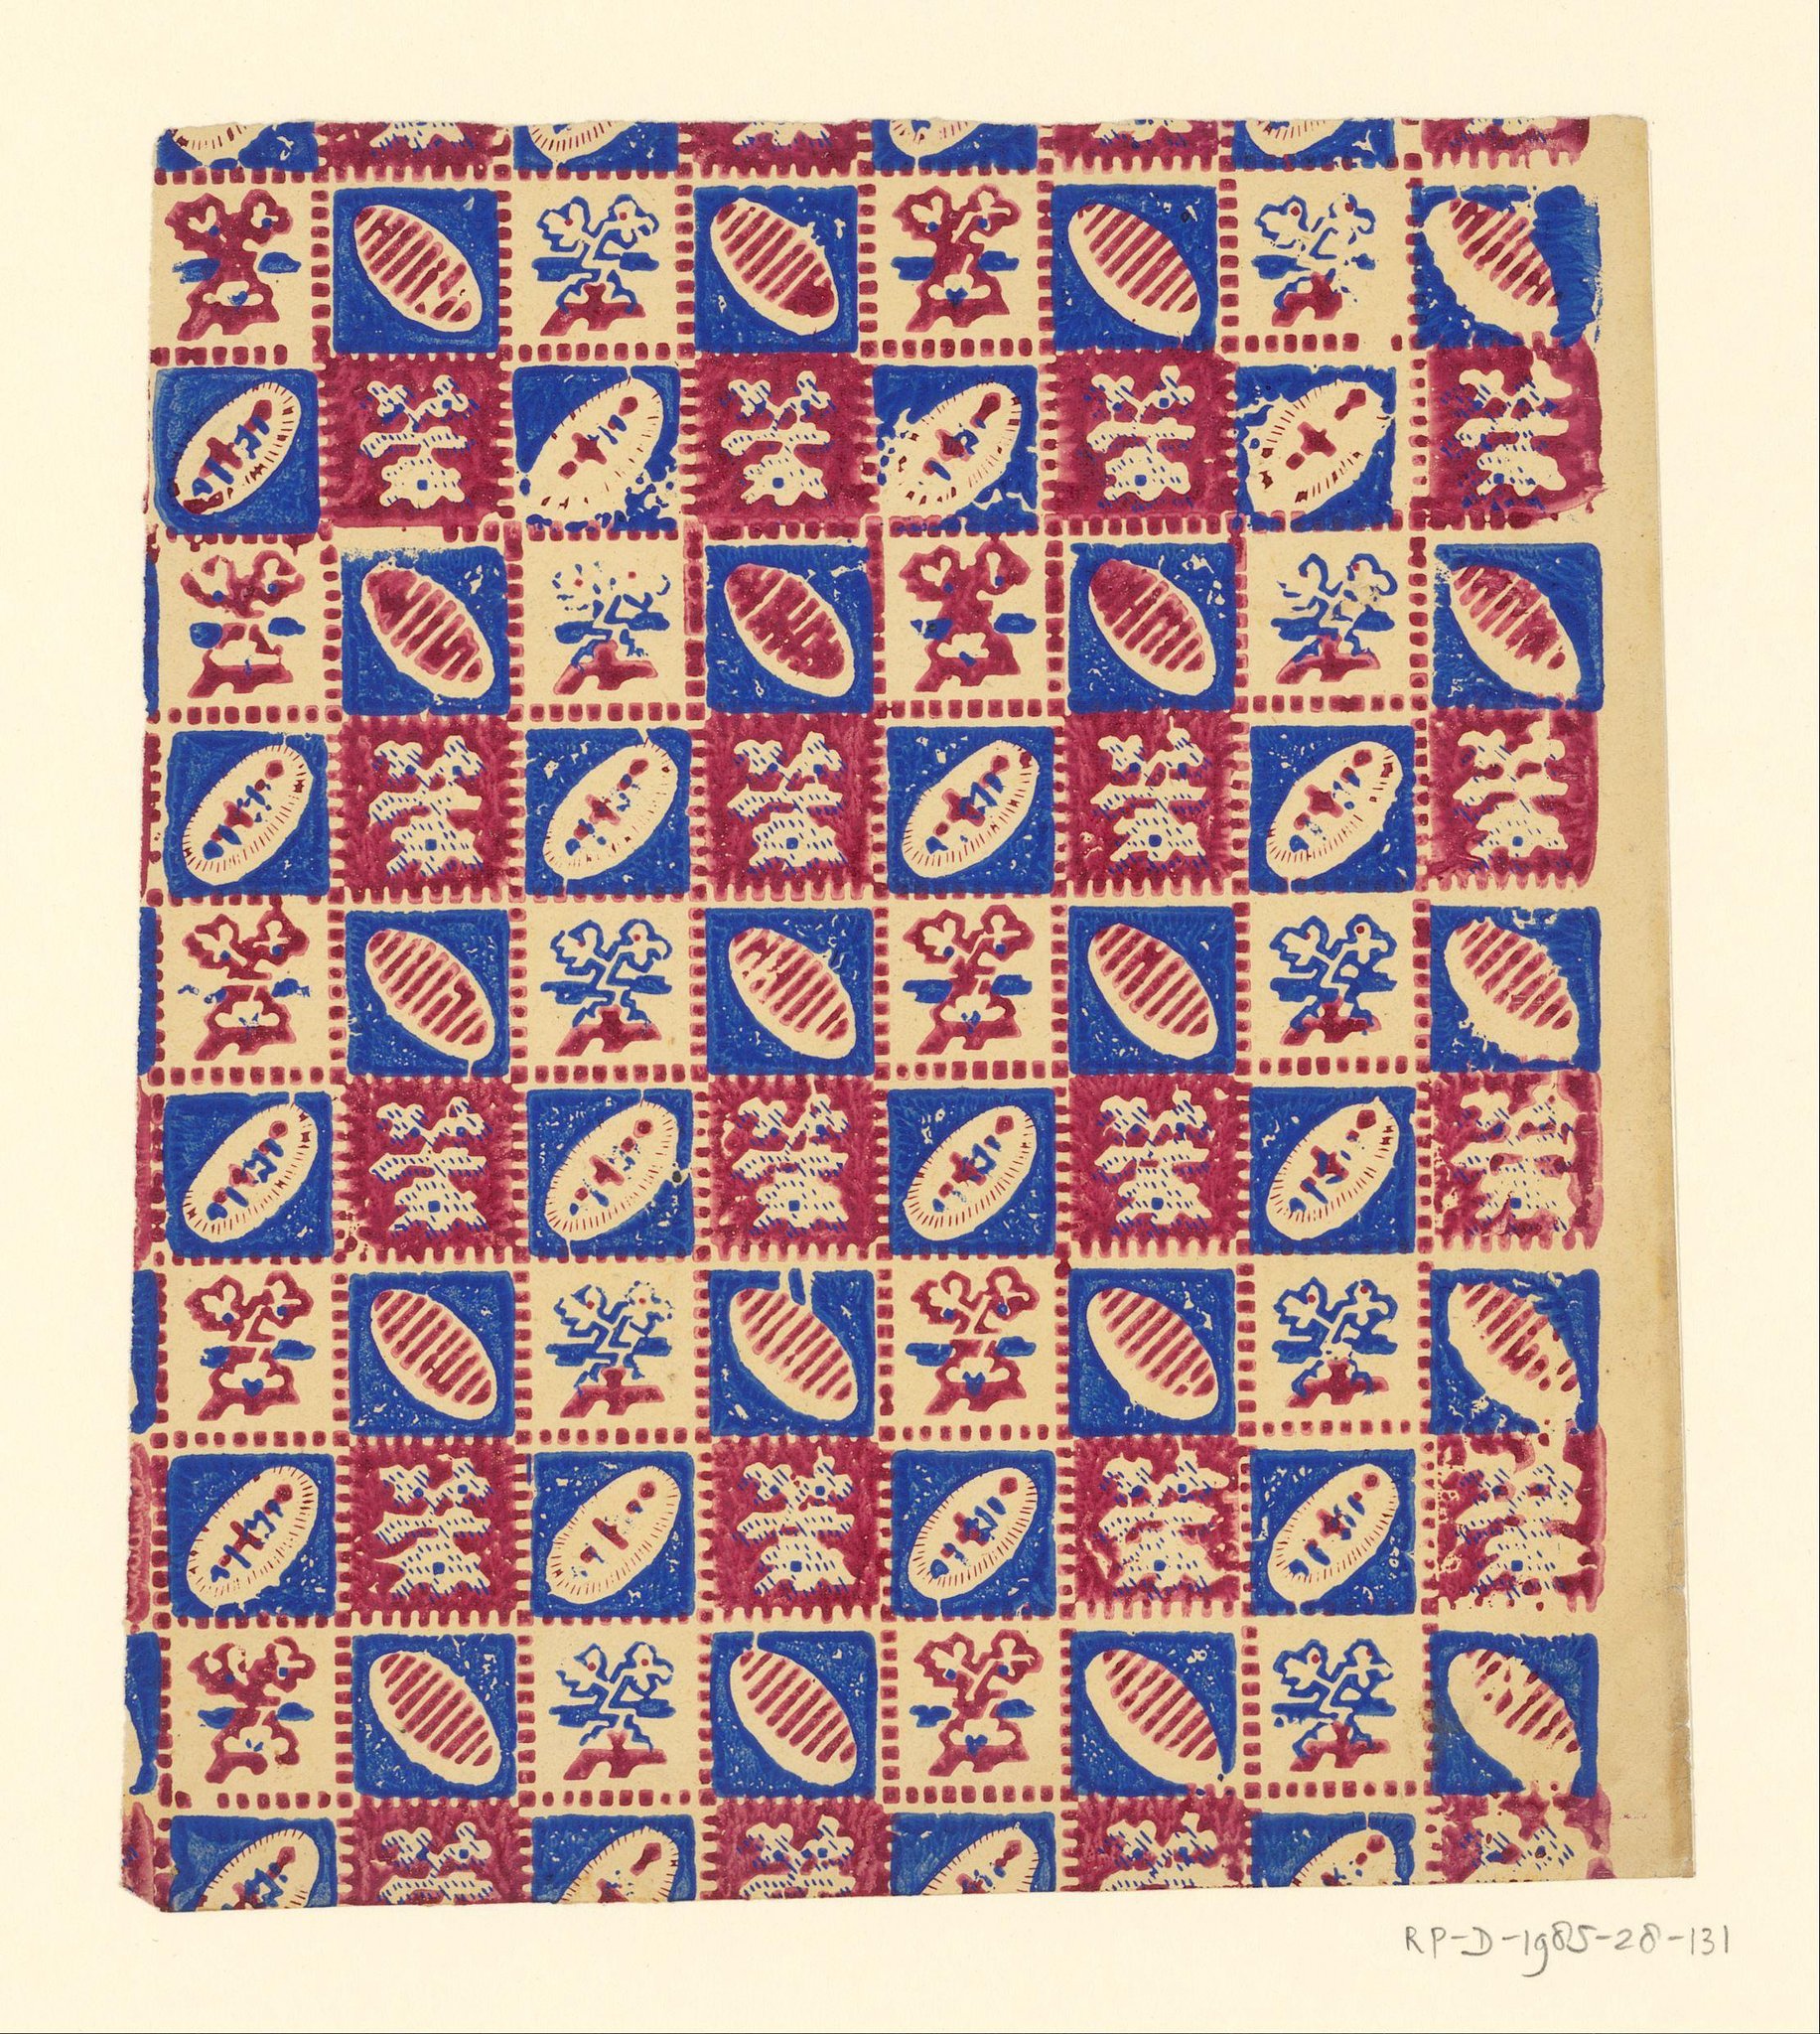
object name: printed paper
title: Blad met schaakbordpatroon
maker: Anonymous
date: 1750-1900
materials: paper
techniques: printing block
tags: fantasy ornament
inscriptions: collector's mark: Lugt 2760, collector's mark: Lugt 2228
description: Blad met schaakbordpatroon. Waarschijnlijk de helft van een omslag.